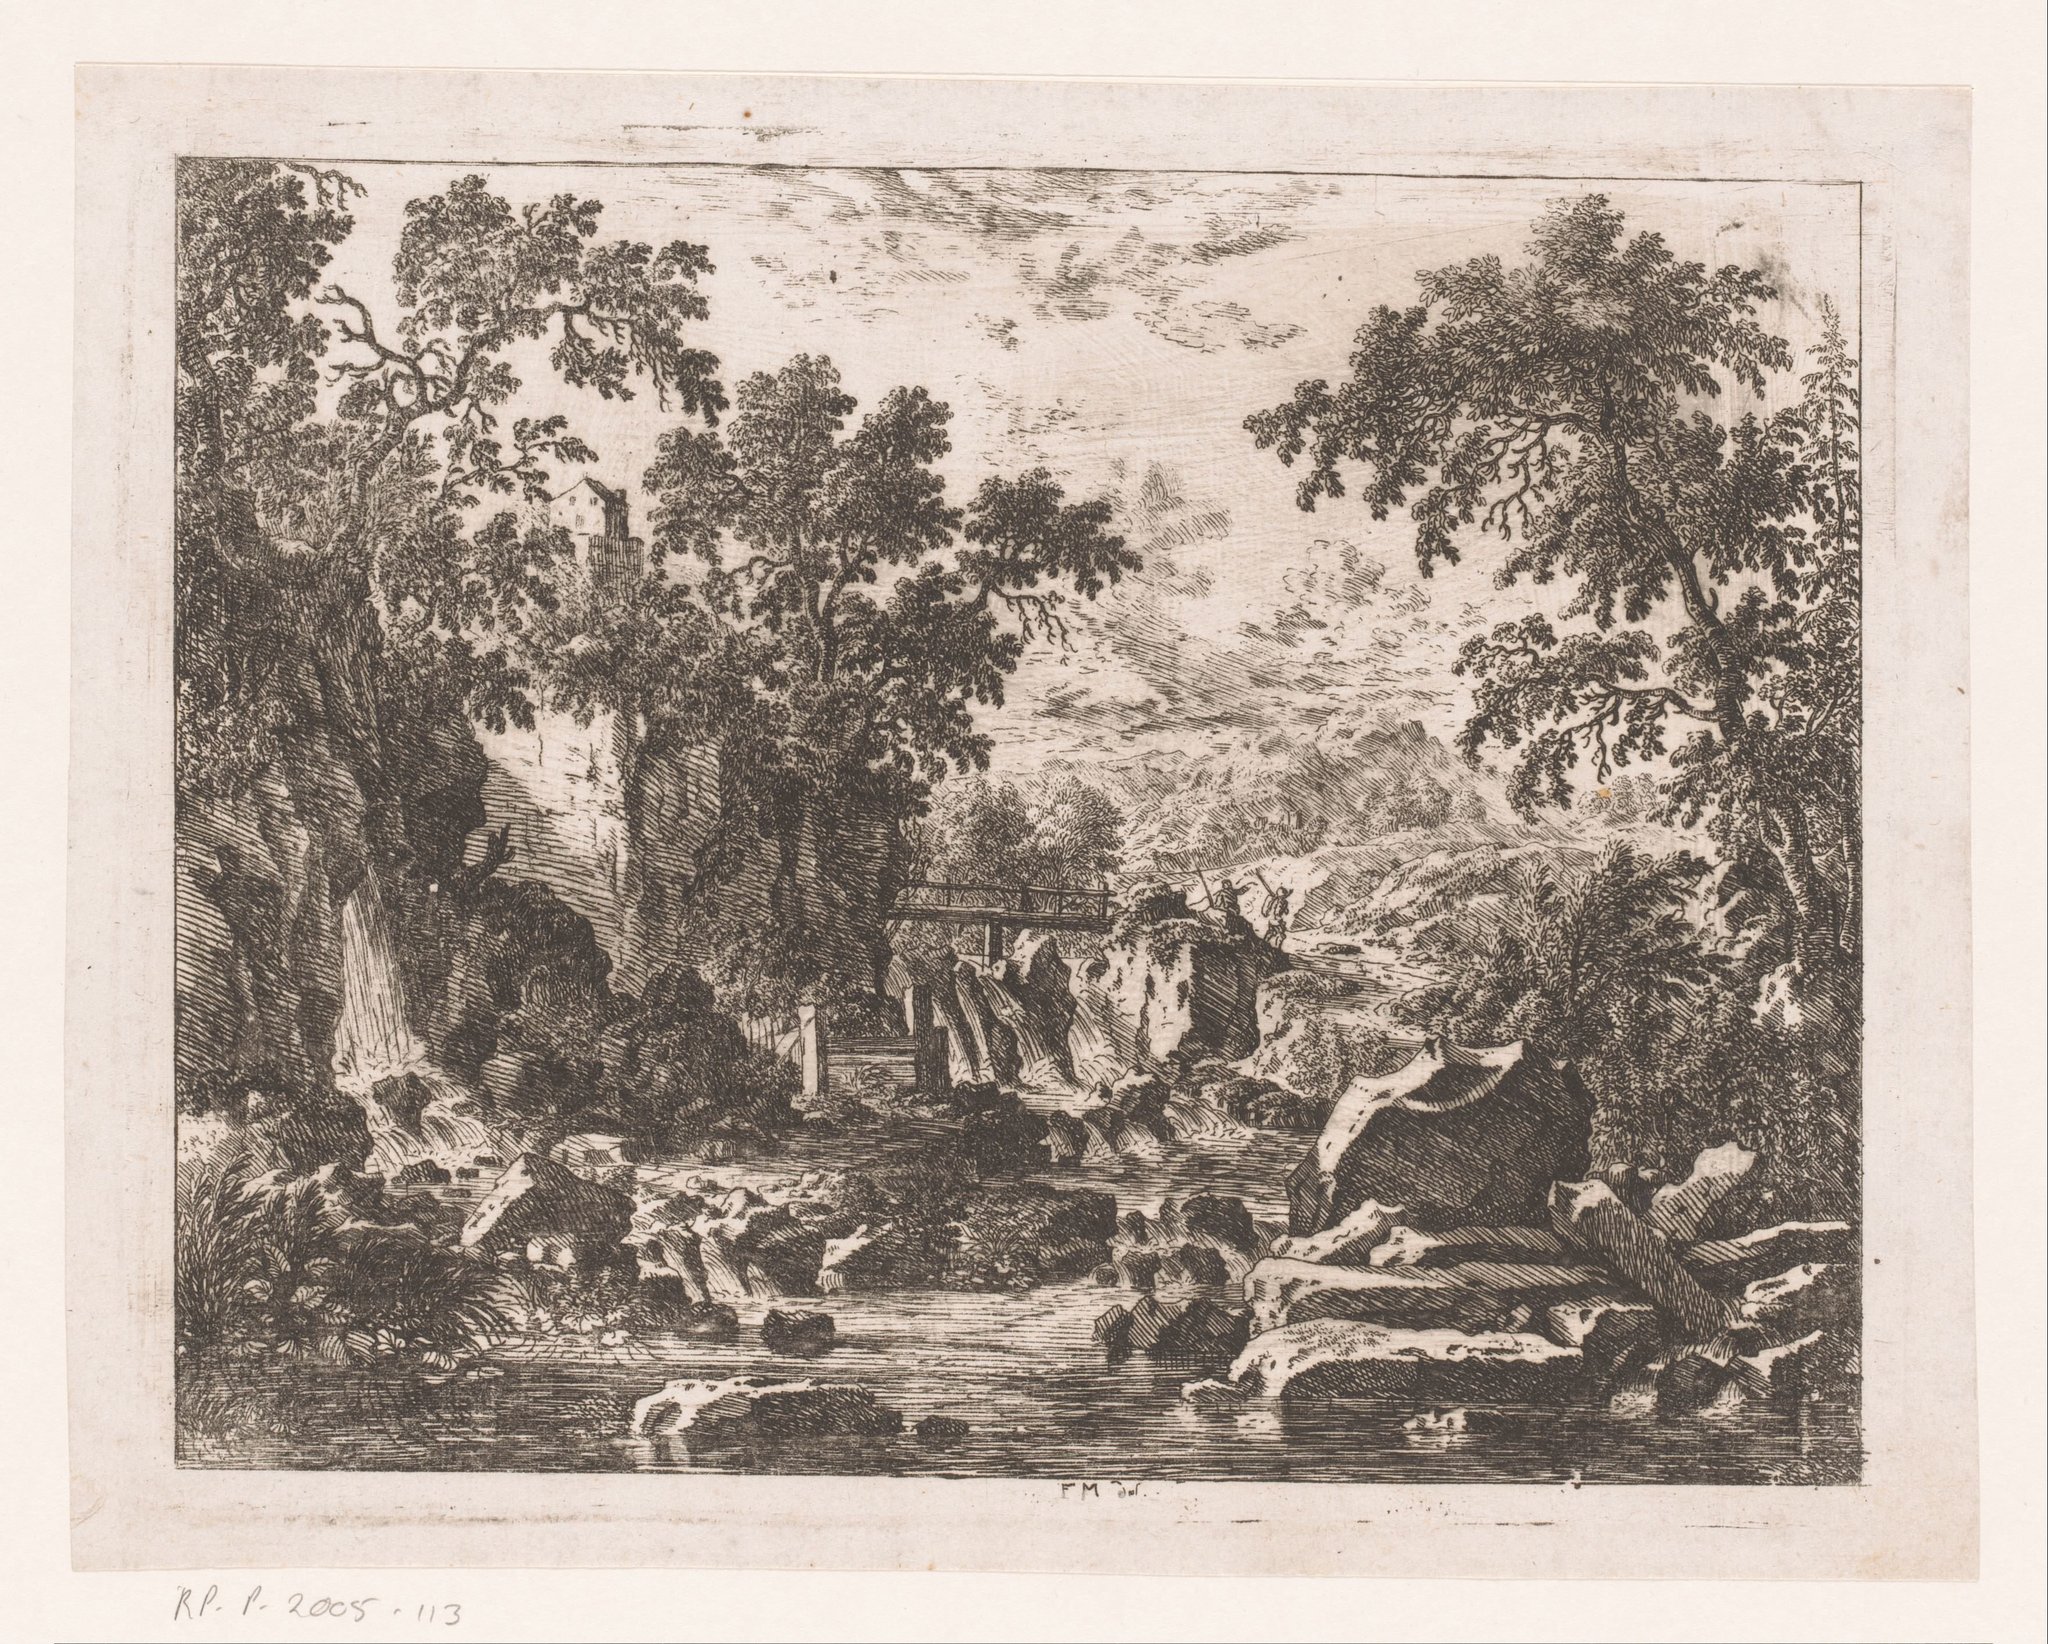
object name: print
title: Zes landschappen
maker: felix meyer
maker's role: print maker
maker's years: 1653-1713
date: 1663-1713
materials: paper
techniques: etching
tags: waterfall, landscape with bridge, viaduct or aqueduct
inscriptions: collector's mark: Lugt 2228